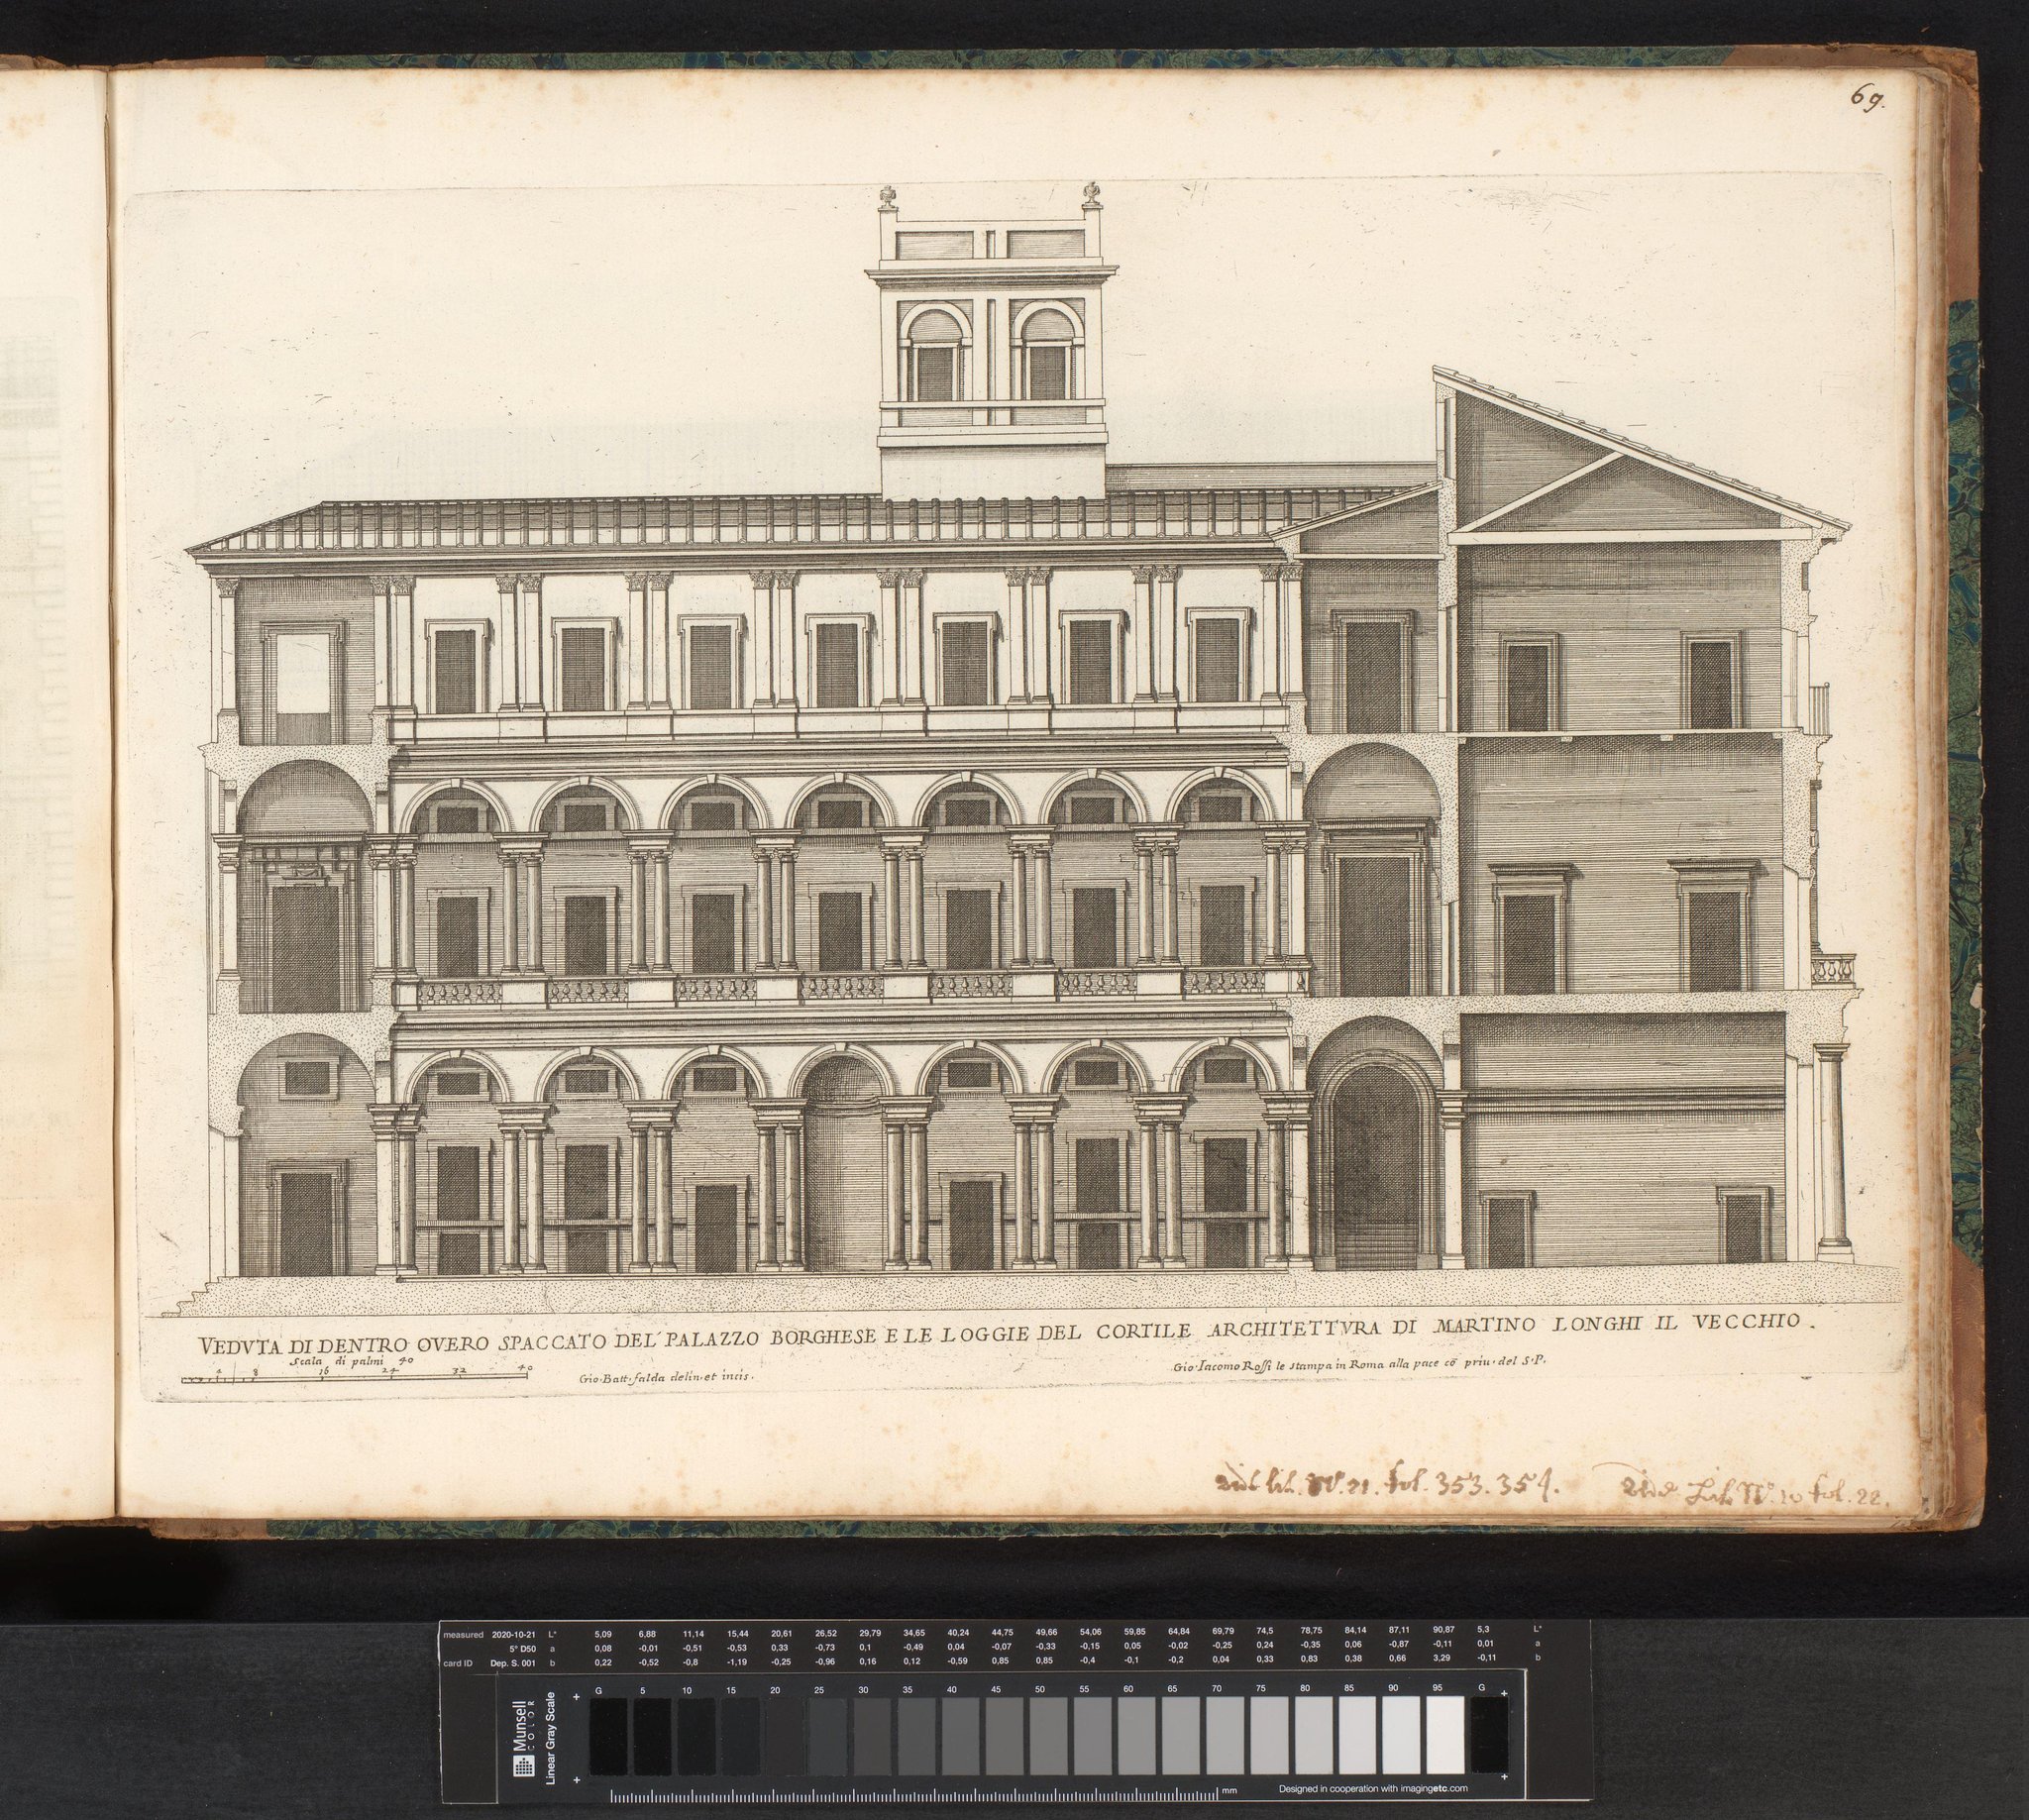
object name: print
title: Veduta di dentro overo spaccato del' Palazzo Borghese e le loggie del cirtile architettura di Martino Longhi il vecchio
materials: paper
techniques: etching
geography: italy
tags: palace, façade (of house or building), inner court of palace or 'hôtel'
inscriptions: number: ‘69’, inscription: ‘Ende lib. No. 21. fol. 353. 354./ Ende lib. No. 10. fol. 22.’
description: Deze prent maakt deel uit van de reeks getiteld: Palazzi di Roma. Deze reeks bestaat uit twee boeken. Boek één getiteld: Palazzi di Roma dei più celebri architetti..., bestaat uit 44 prenten die worden toegeschreven aan Giovanni Battista Falda (naam staat enkel op prent 27) en uitgegeven door Giovanni Giacomo de'Rossi. Deze 44 prenten zijn bekend in twee staten (met en zonder nummer). Boek twee getiteld: Nuovi disegni dell'architetture... libro secondo, bevat 66 prenten door Giovanni Battista Falda en Simone Felice. Deze 66 prenten zijn bekend in twee staten (met en zonder nummer).